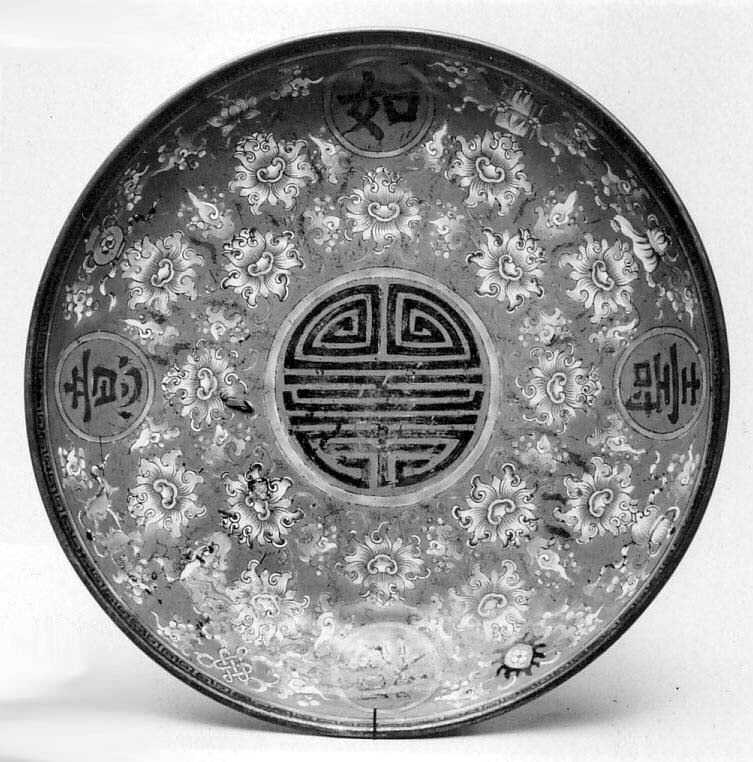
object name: saucer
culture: chinese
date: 1801-1900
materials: enamel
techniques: painting